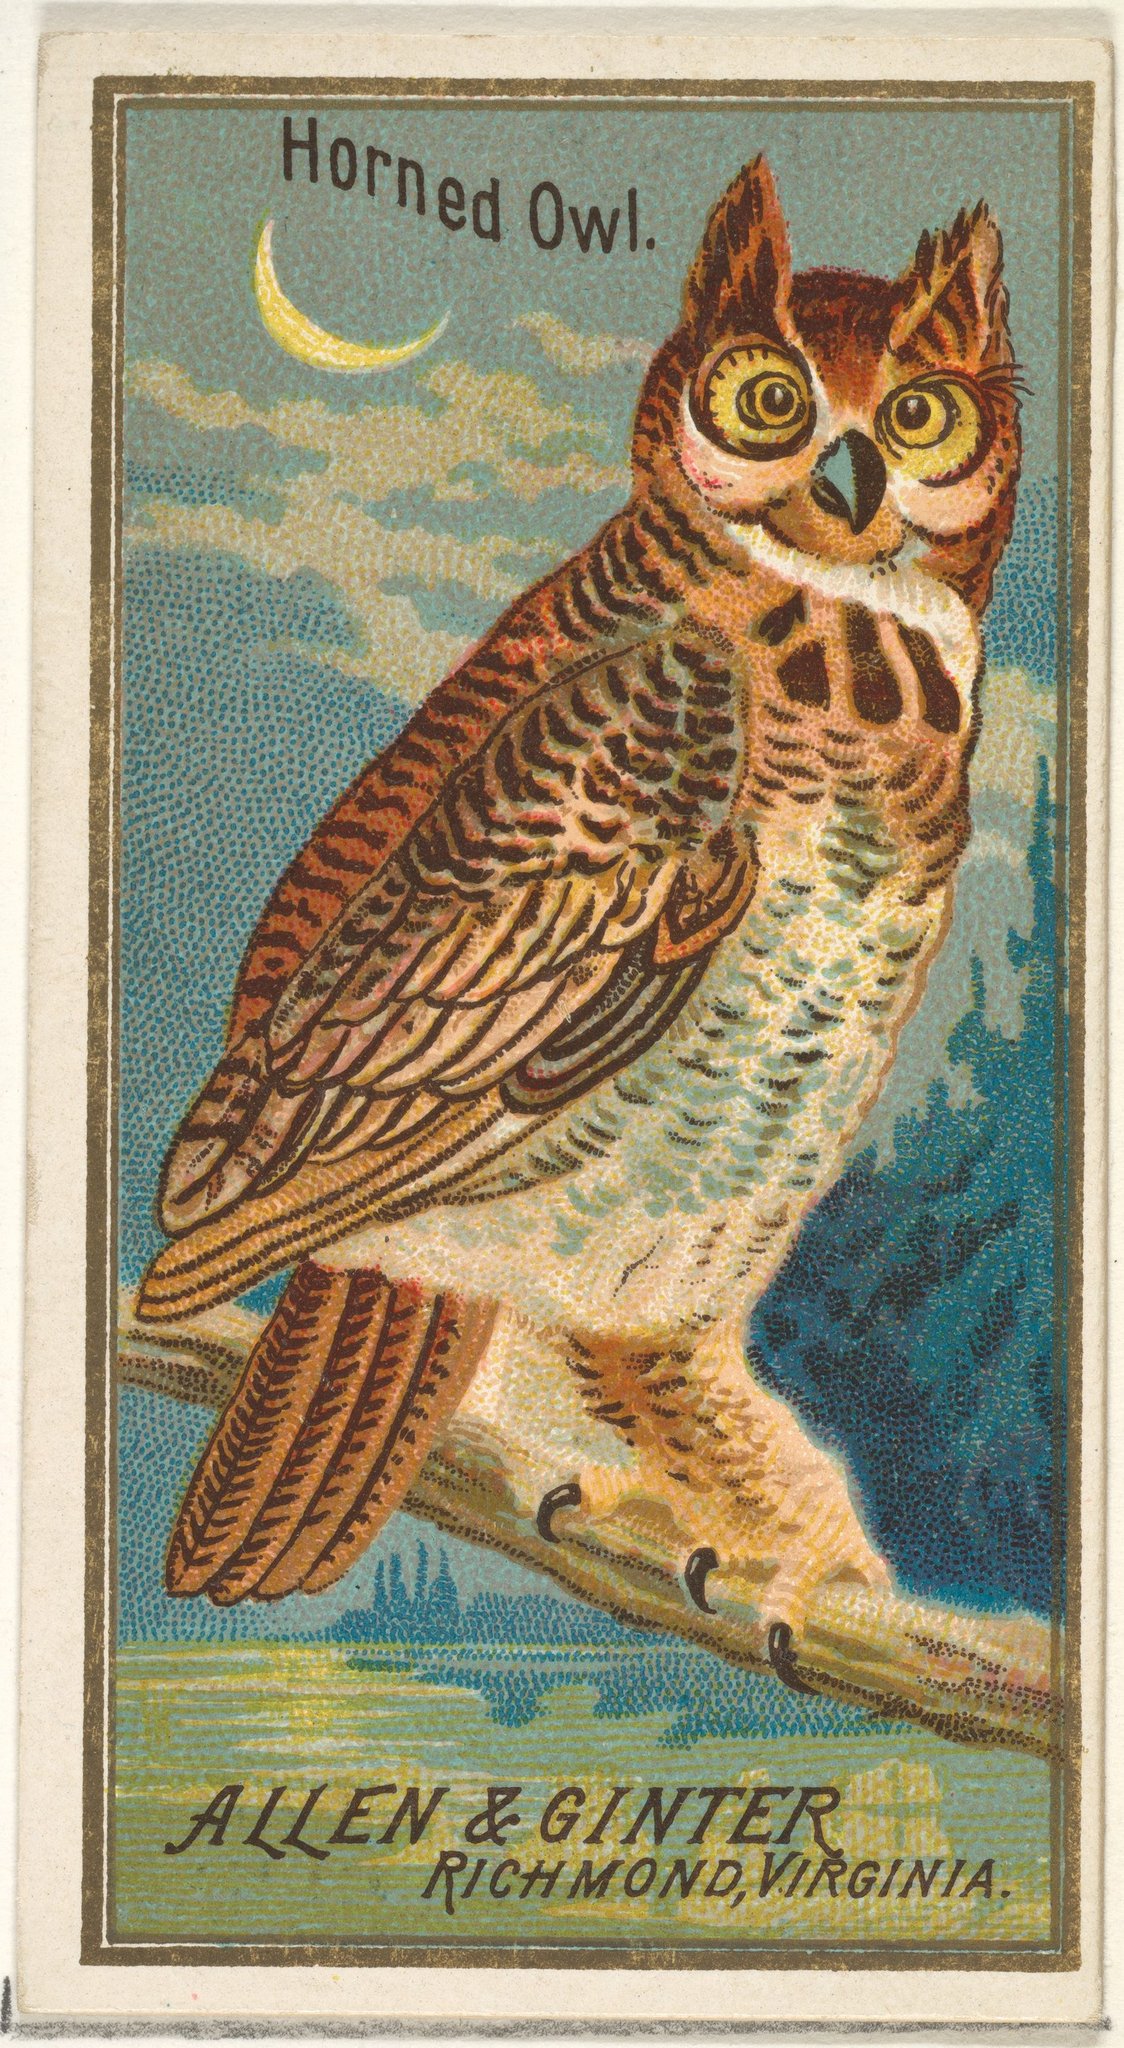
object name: print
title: Horned Owl, from the Birds of America series (N4) for Allen & Ginter Cigarettes Brands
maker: allen & ginter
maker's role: publisher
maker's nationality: american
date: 1888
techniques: color lithograph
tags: owls